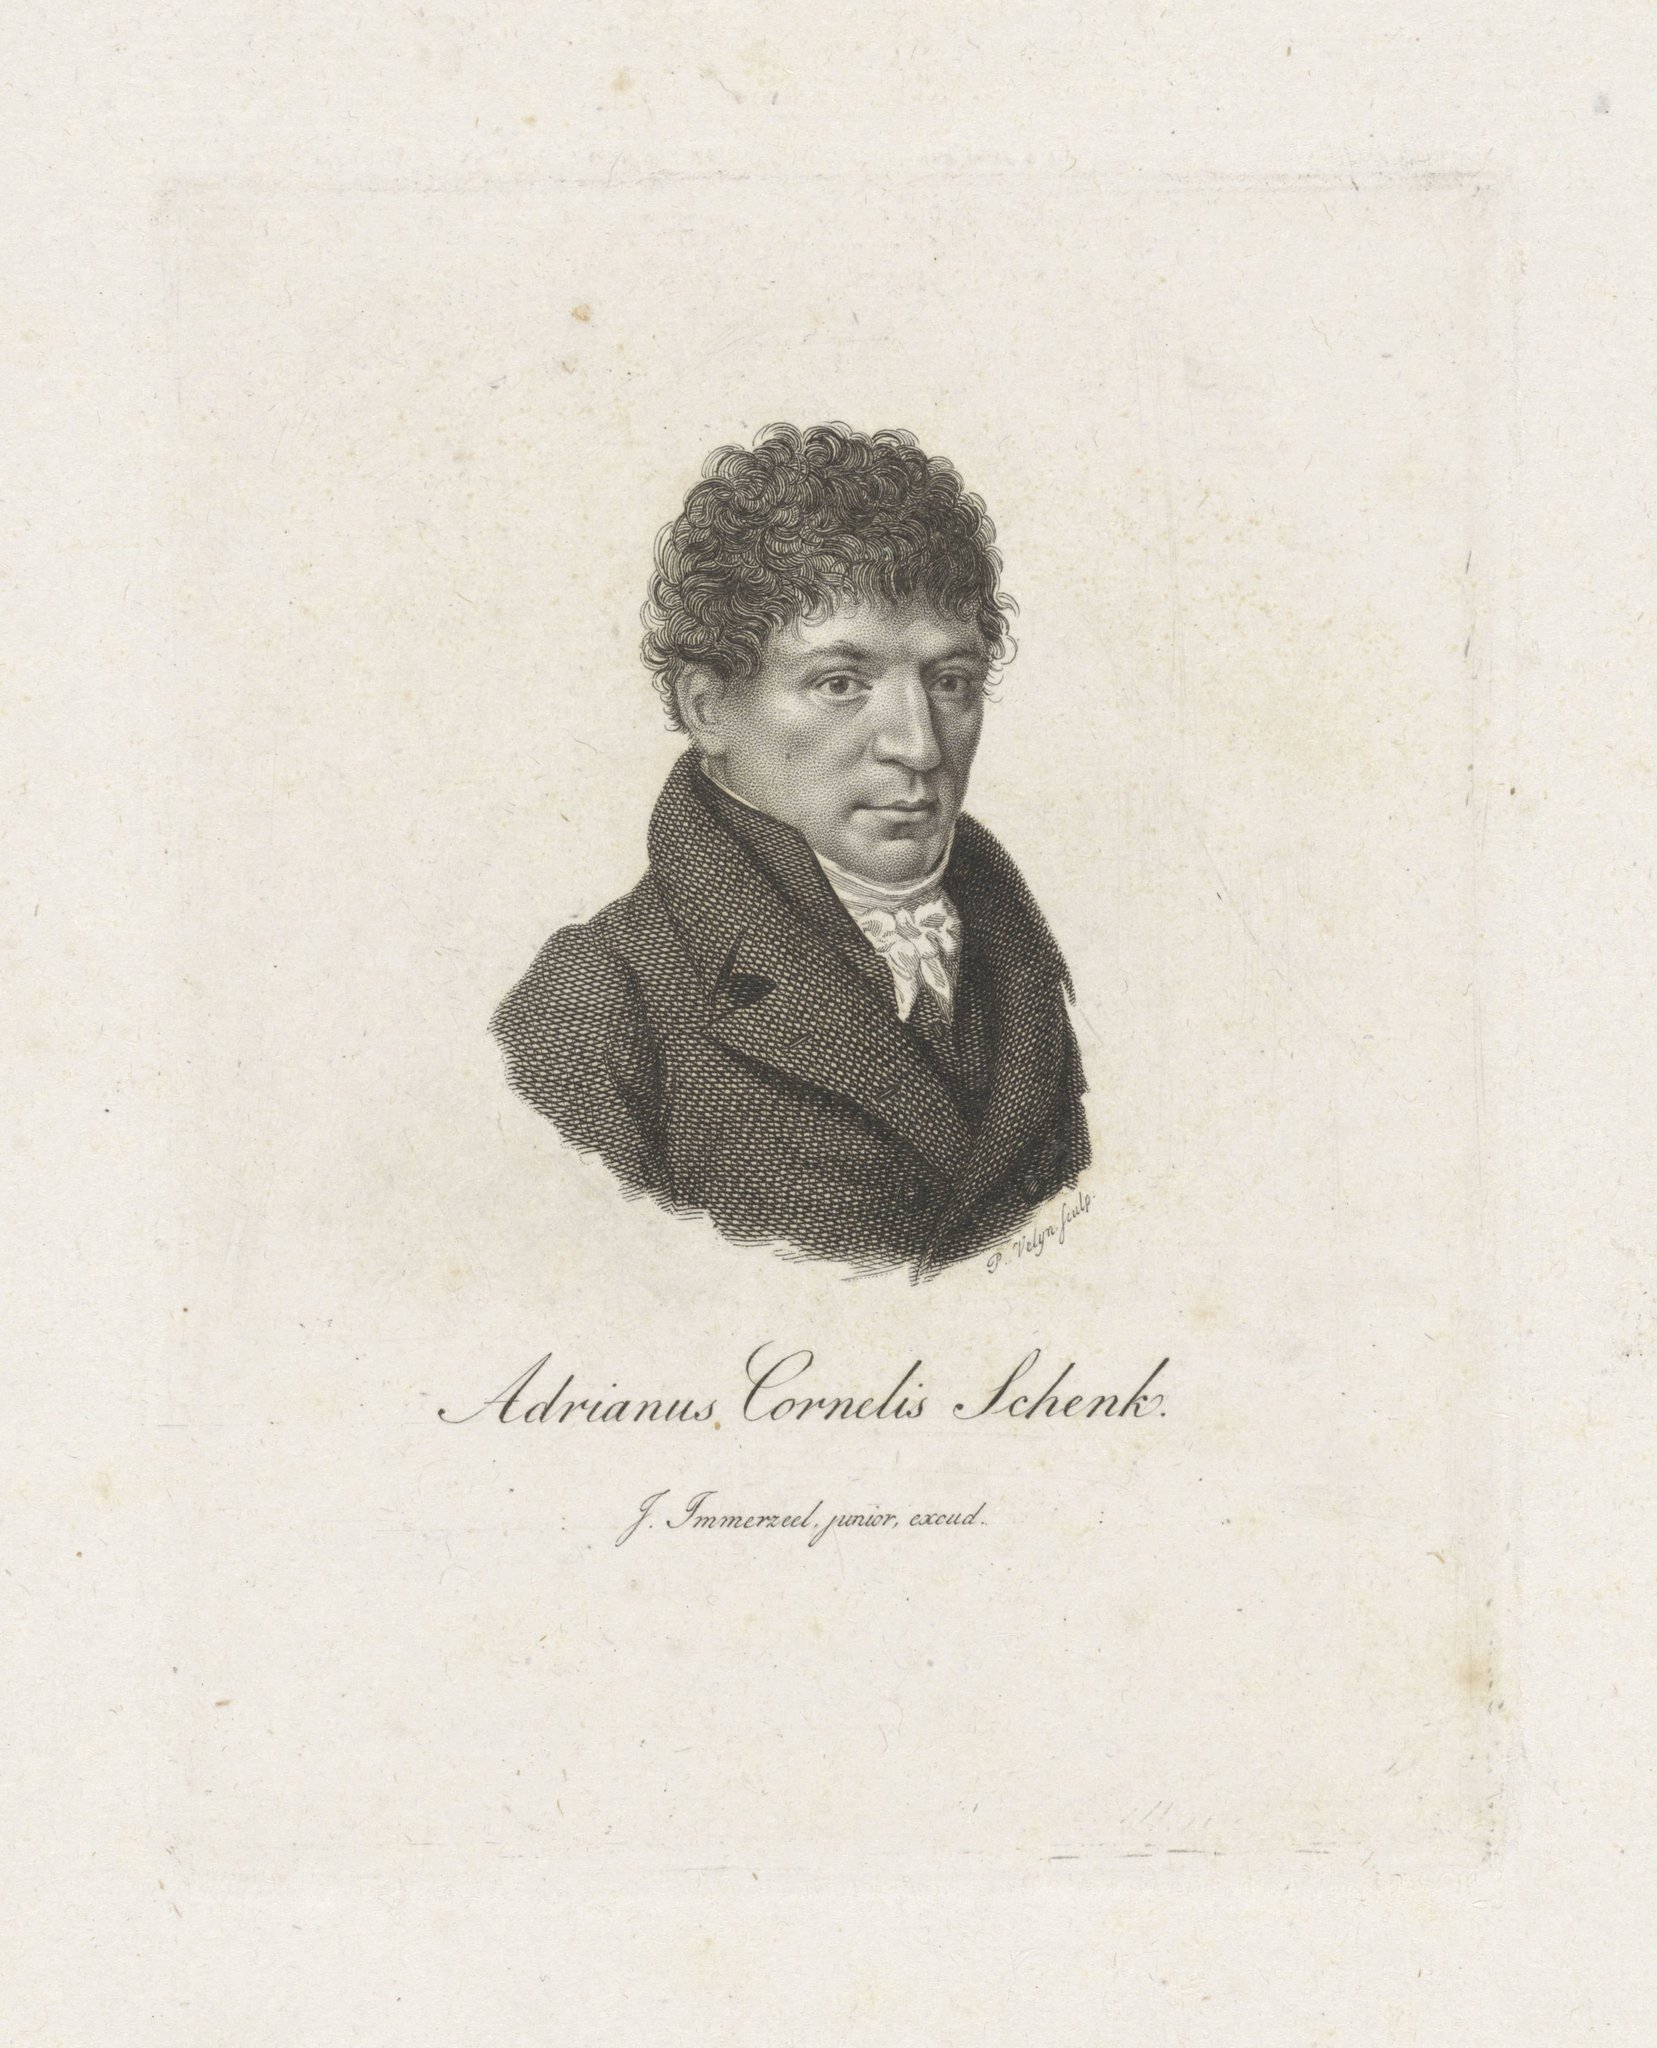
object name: print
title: Portret van Adrianus Cornelis Schenk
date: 1832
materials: paper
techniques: engraving, etching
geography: netherlands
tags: dichter, adrianus cornelis schenk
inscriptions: collector's mark: Lugt 2228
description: Portret van de dichter en vertaler Adrianus Cornelis Schenk.